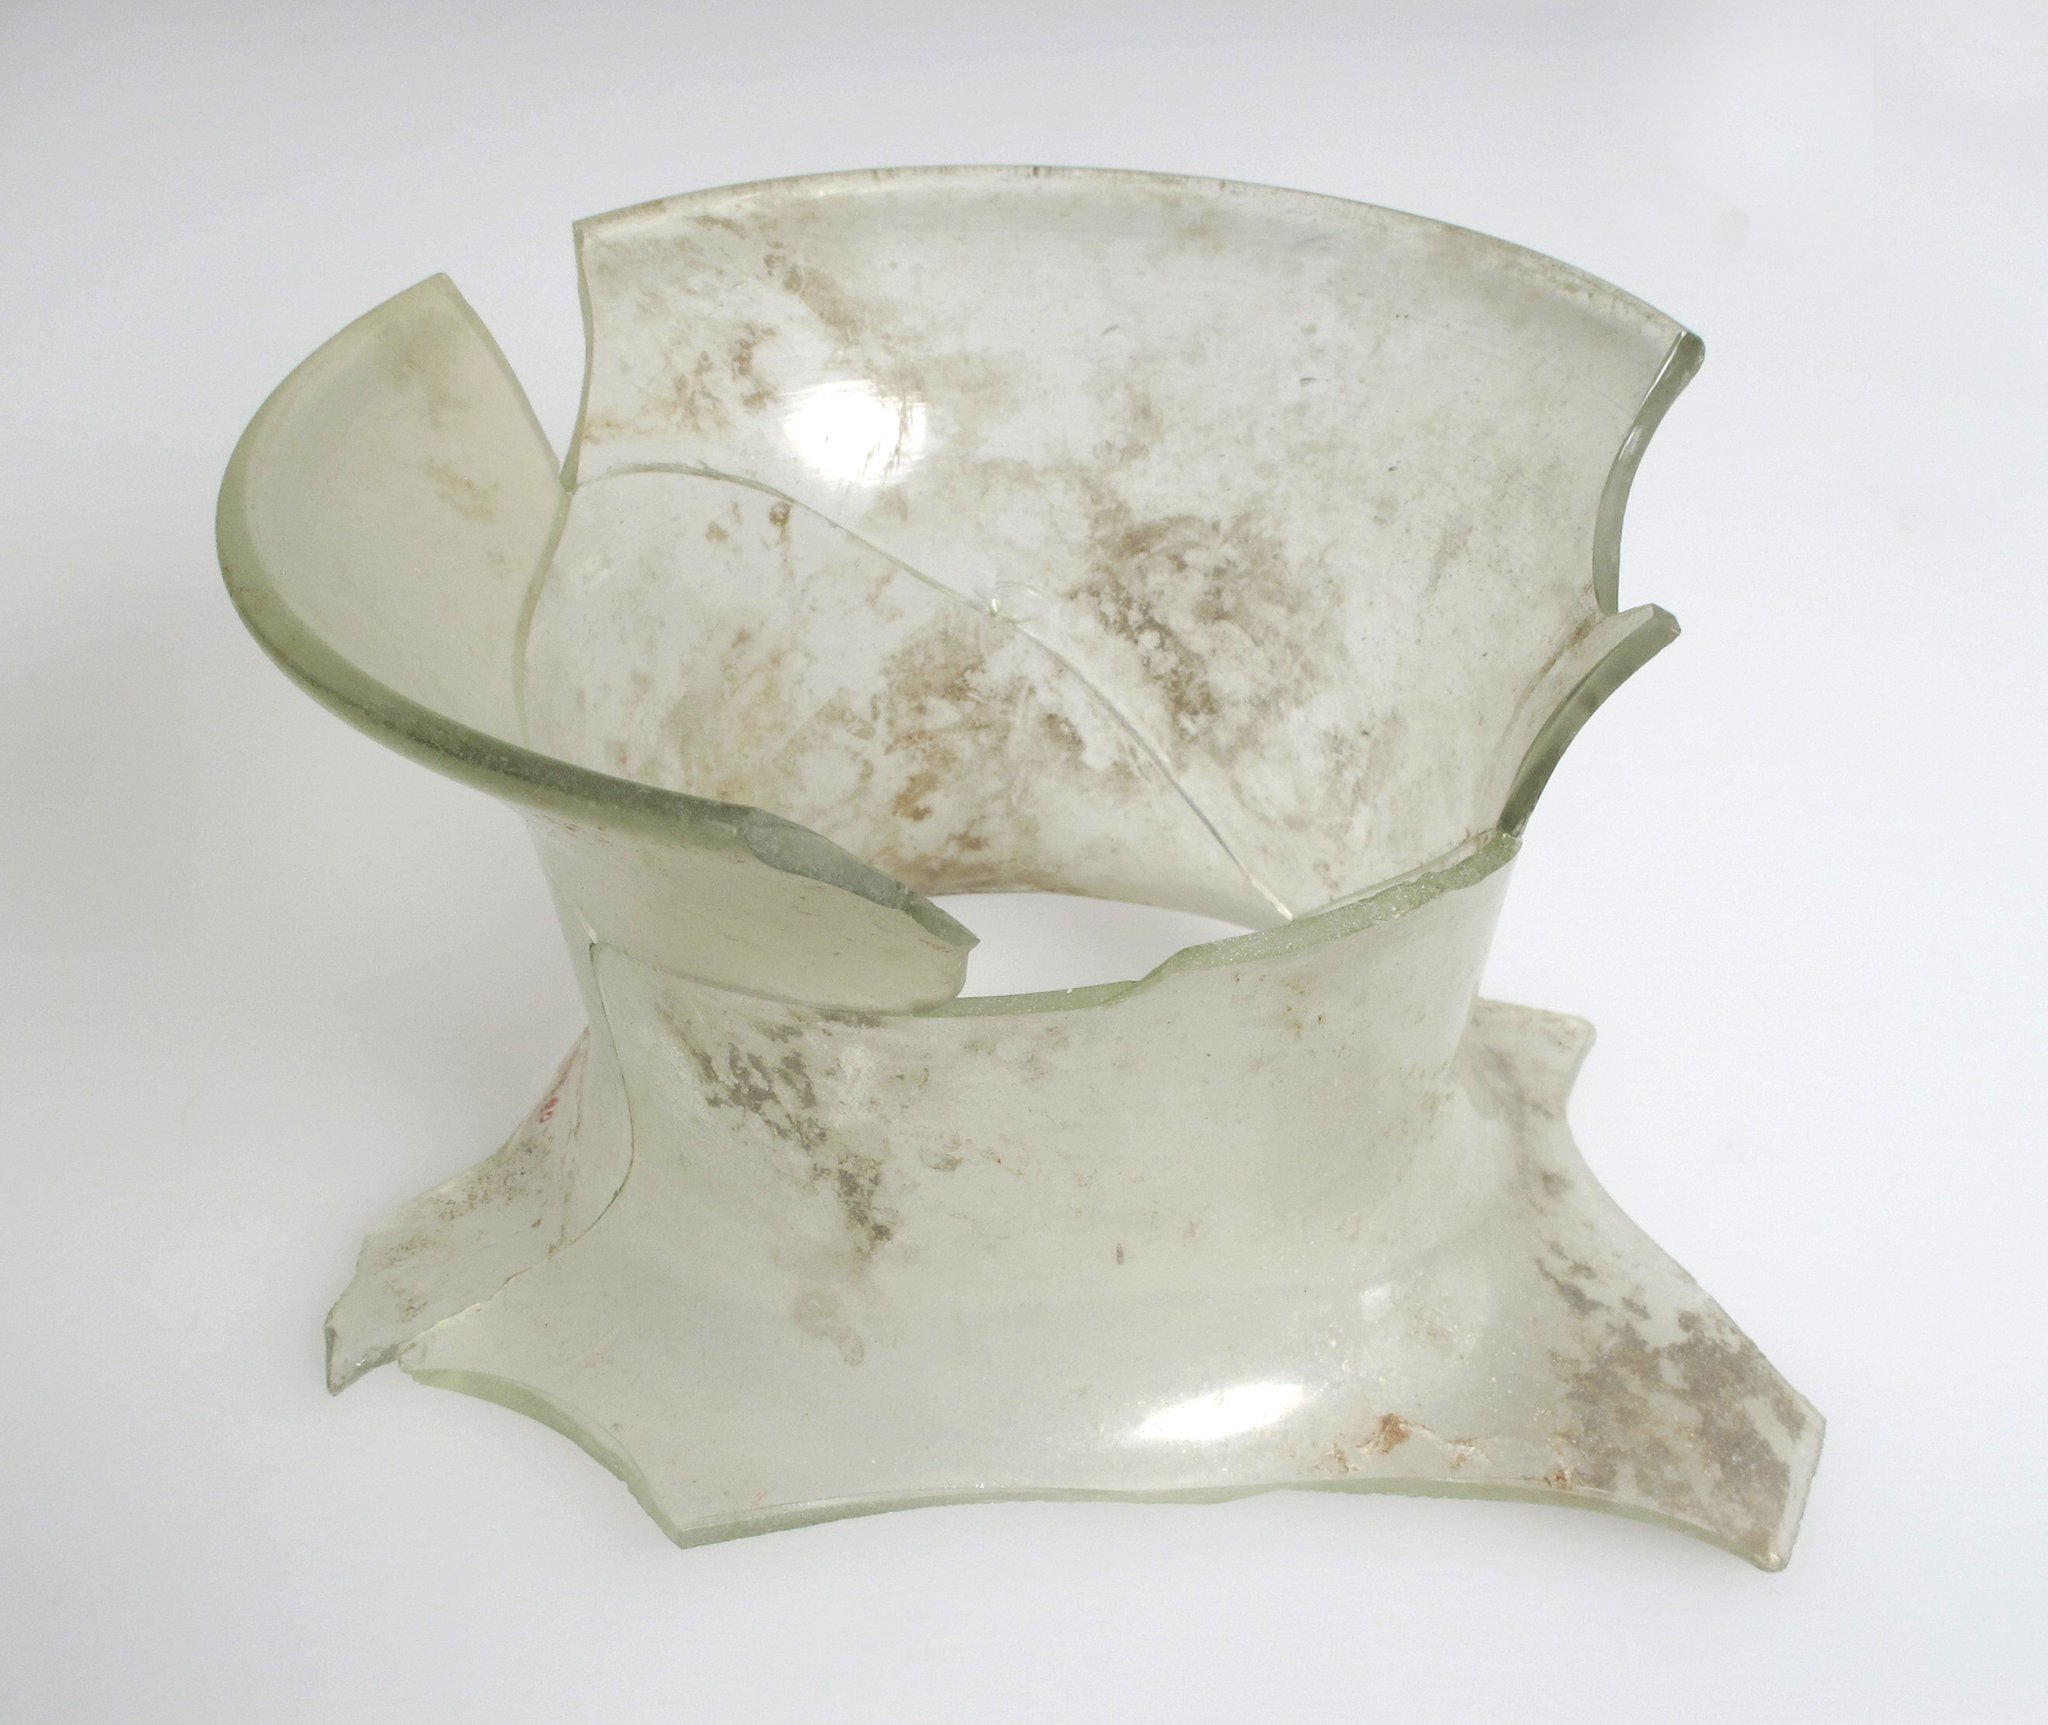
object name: fragment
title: Neck of a Vessel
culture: coptic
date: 301-433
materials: glass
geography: egypt